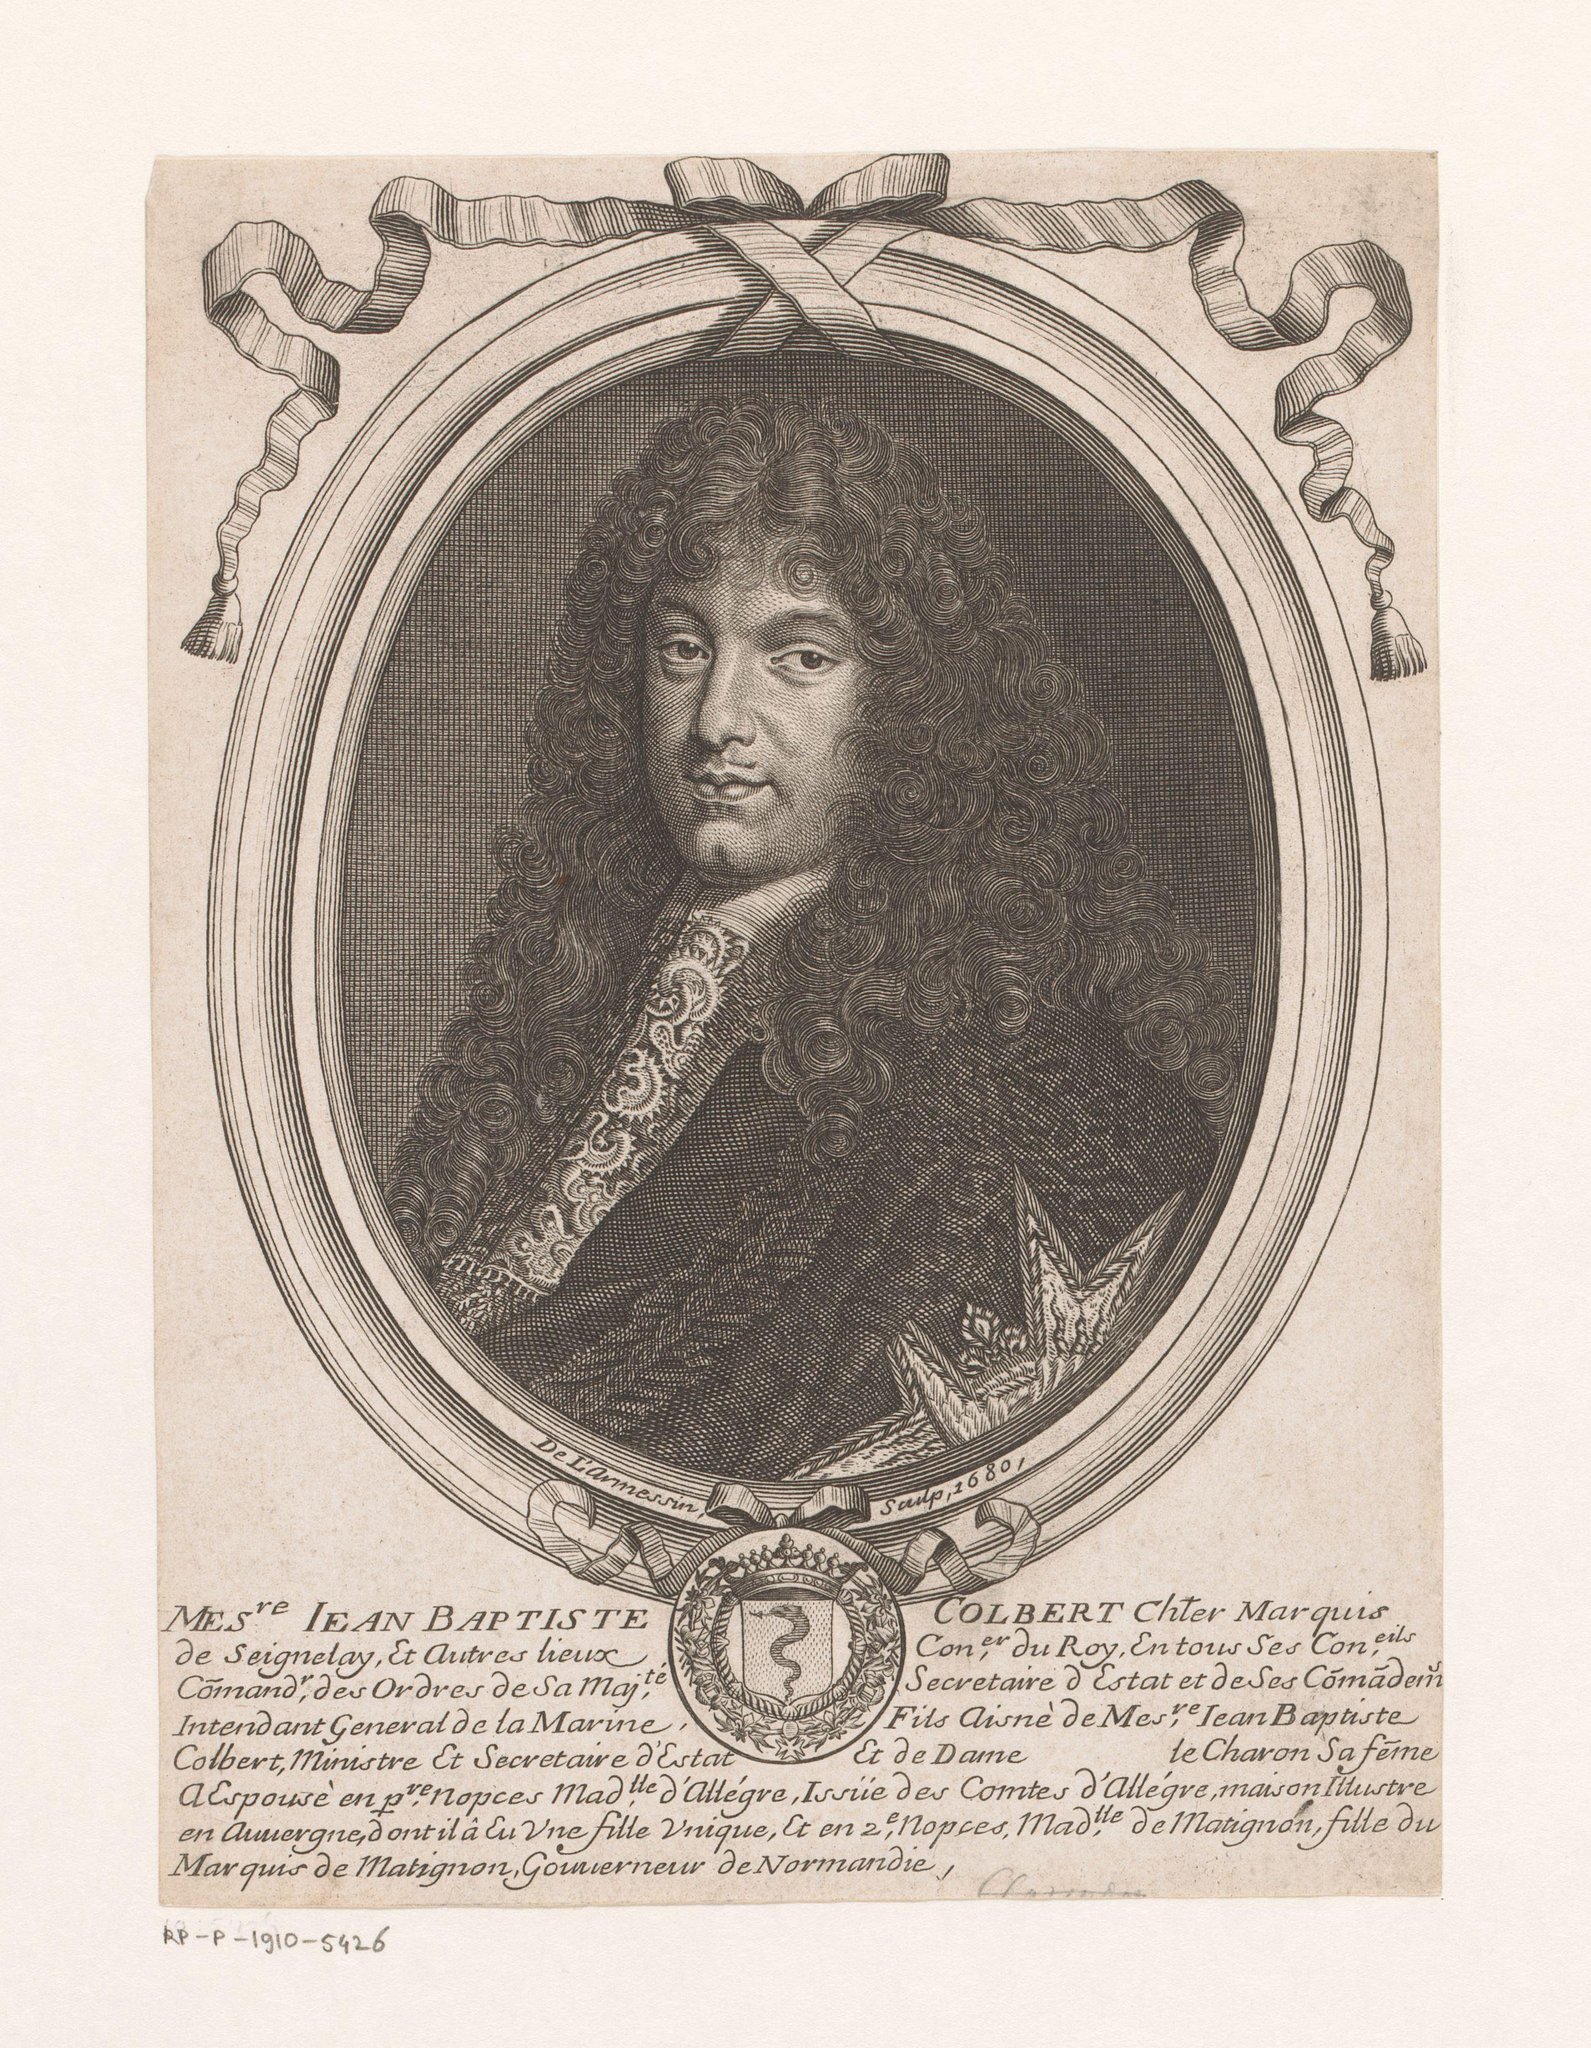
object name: print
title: Portret van Jean-Baptiste Colbert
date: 1680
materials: paper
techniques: engraving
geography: france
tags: paris, politician, jean-baptiste colbert, historical persons, politician, e.g. party leader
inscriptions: collector's mark: Lugt 2228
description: Maakt deel uit van een grootschalige serie met portretten van prominente figuren. Binnen de serie bevindt zich een sectie getiteld 'Les Augustes Représentations De tous les Roys De France depuis Pharamond Iusqu'à Louys XIIII'. De serie werd respectievelijk uitgegeven door Pierre Bertrand, door zijn weduwe en door De Larmessin zelf.